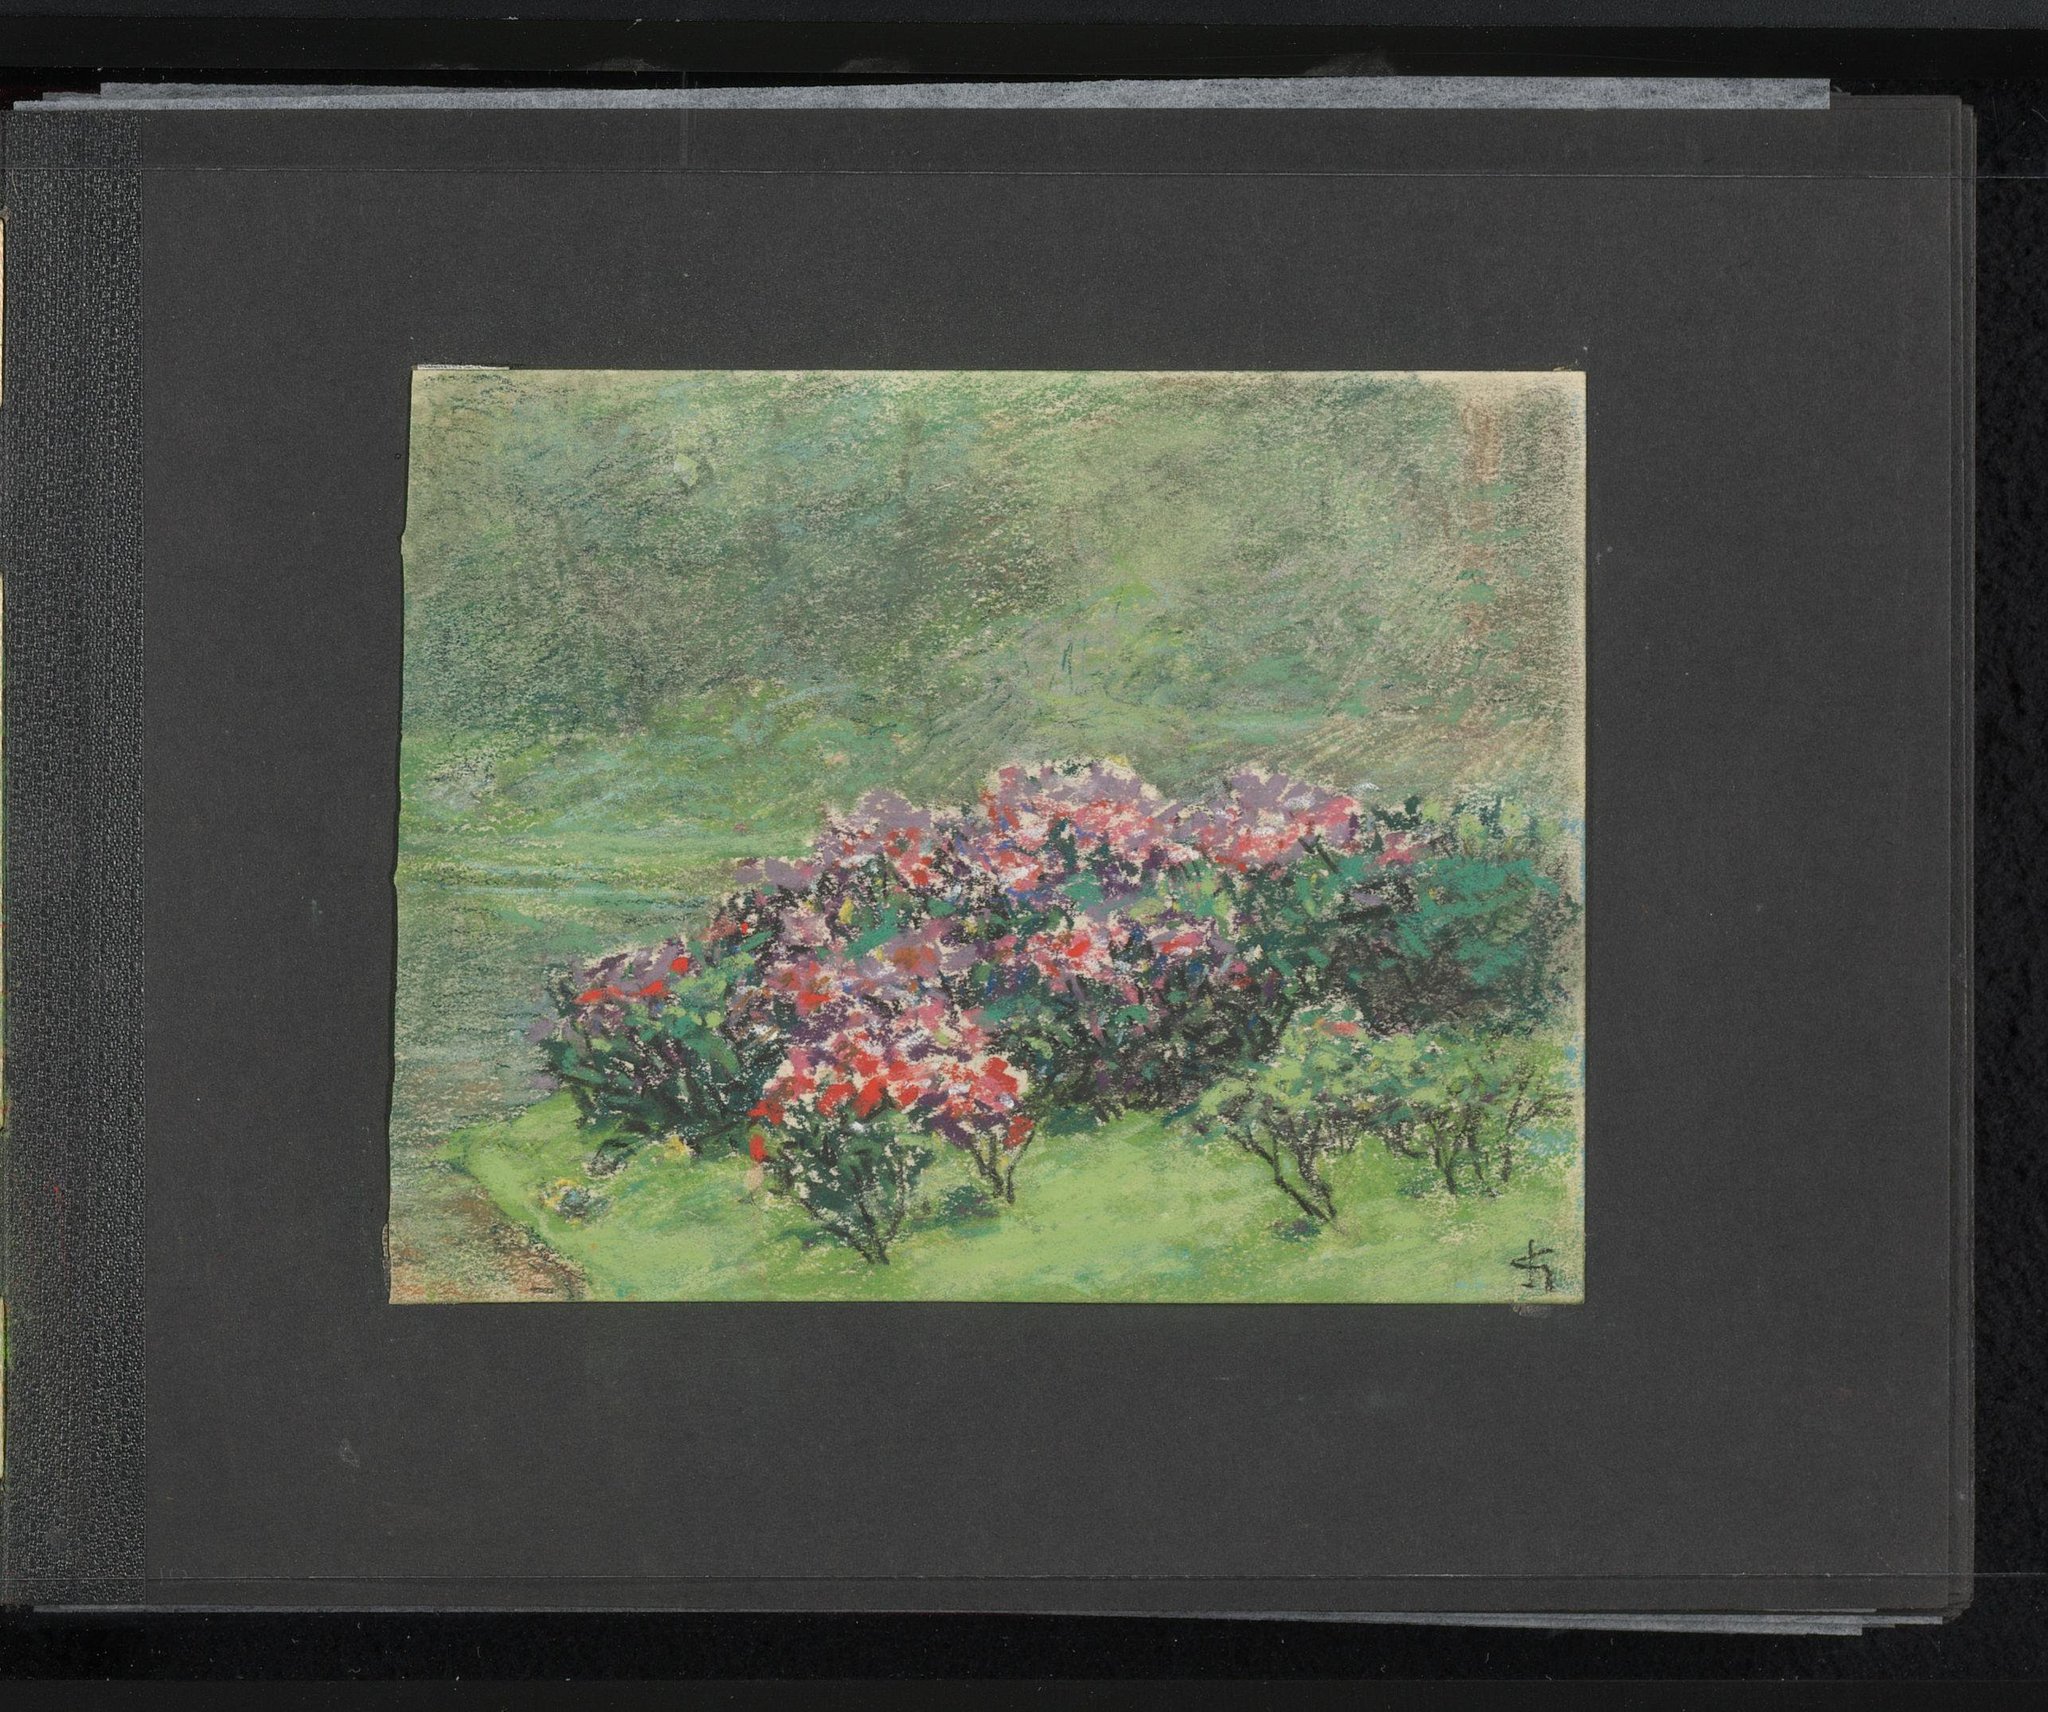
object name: album leaf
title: Waterkant met bloemen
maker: carel nicolaas storm van s-gravesande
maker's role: draughtsman, print maker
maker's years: 1841-1924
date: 1915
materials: chalk, paper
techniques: pasting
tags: flowers, garden pond, public gardens, park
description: Waarschijnlijk te Wiesbaden. Tekening maakt deel uit van een album.